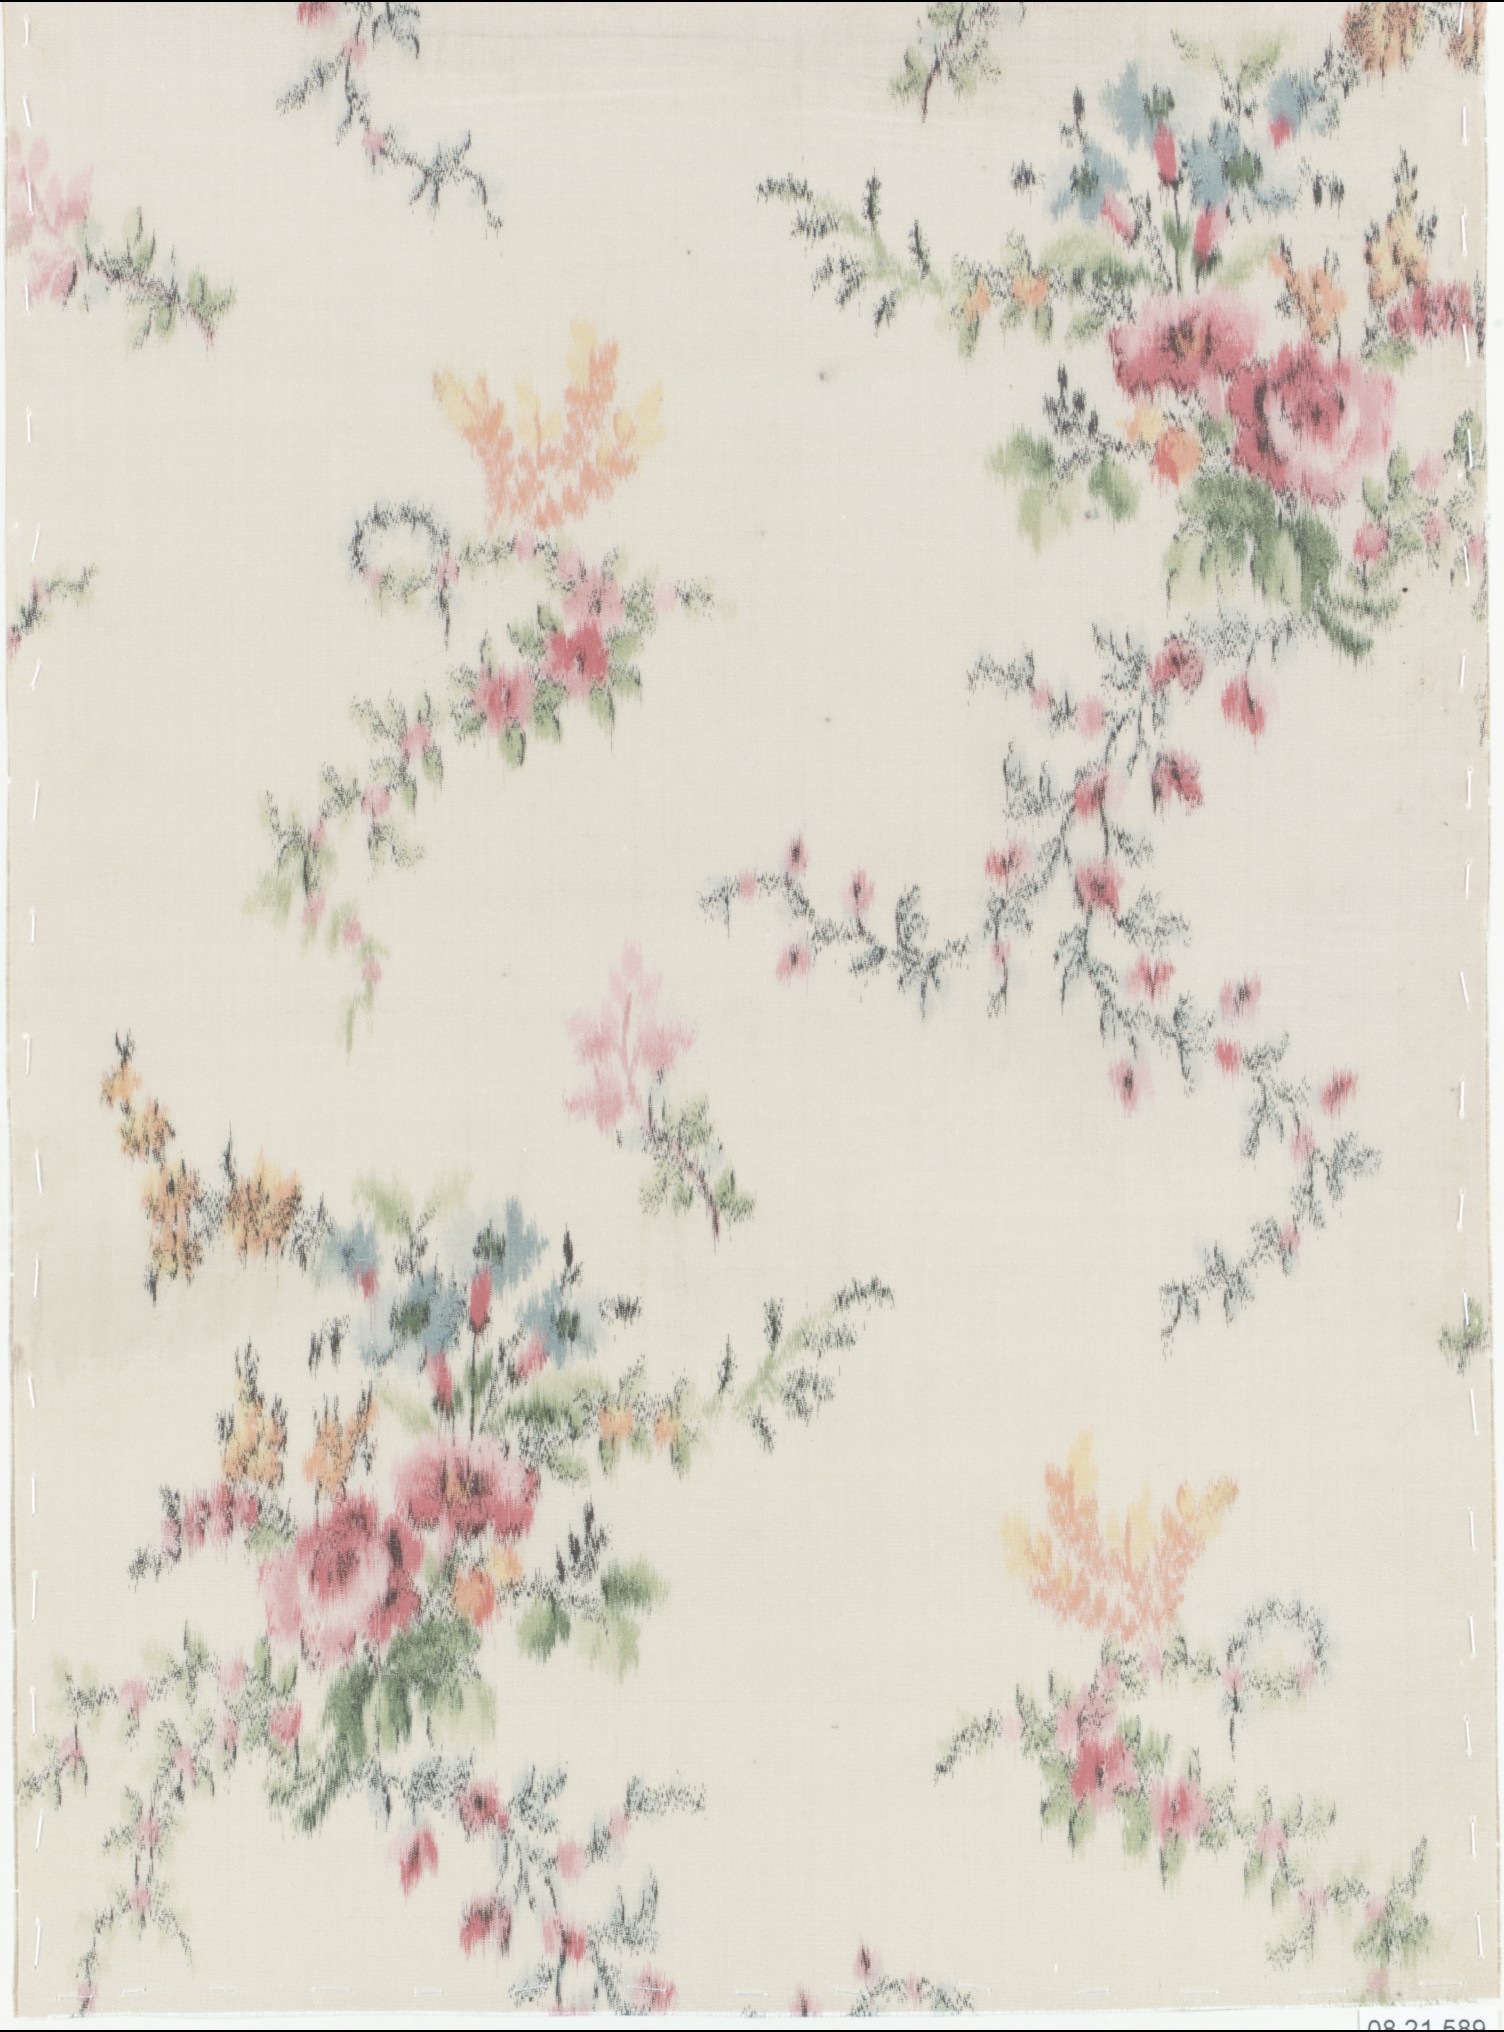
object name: textile sample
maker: Anonymous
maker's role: designer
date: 1900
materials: silk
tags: flowers